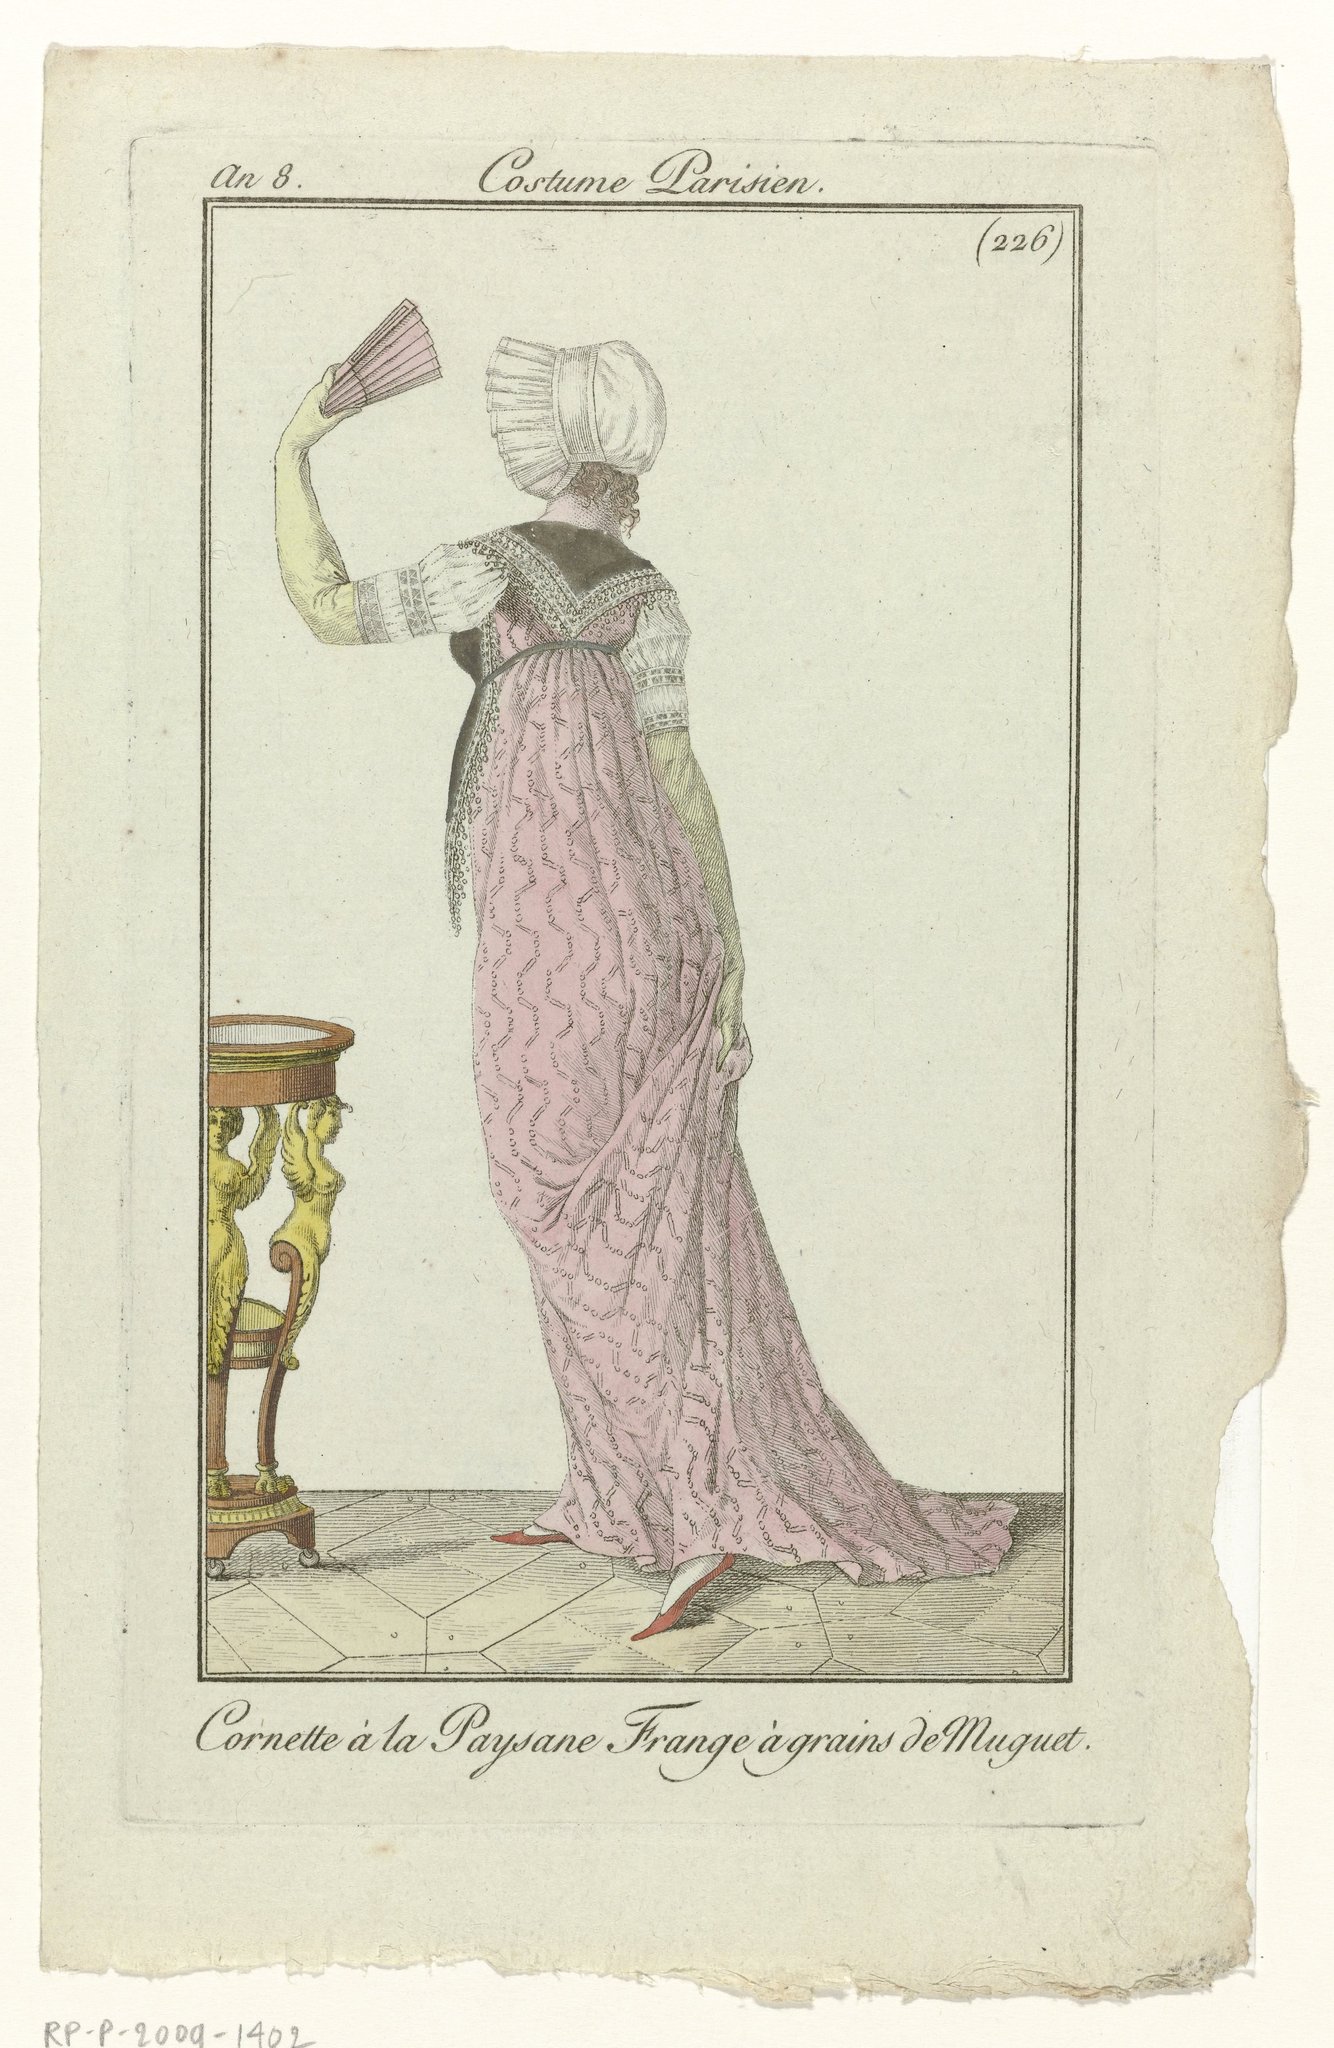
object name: fashion print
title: Journal des Dames et des Modes, Costume Parisien, 29 juin 1800, An 8 (226) : Cornette à la Paysan (...)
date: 1800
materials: paper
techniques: engraving, hand coloring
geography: paris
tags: head-gear (cornette) (+ women's clothes), fashion plates, shoes, sandals (+ women's clothes), gloves, mittens, etc. (+ women's clothes), dress, gown (+ women's clothes), table, fan (+ women's clothes), piece of clothing covering the breast or décolleté (fichu) (+ women's clothes)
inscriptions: caption: ‘Cornette à la Paysane Frange à grains de Muguet.’, title: ‘Costume Parisien.’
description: 'Cornette à la Paysane'. Fichu afgezet met franjes en kralen: 'grains de Muguet'. Japon met sleep en geometrisch zig-zag patroon. Vouwwaaier. De prent maakt deel uit van het modetijdschrift Journal des Dames et des Modes, uitgegeven door Pierre de la Mésangère, Parijs, 1797-1839.